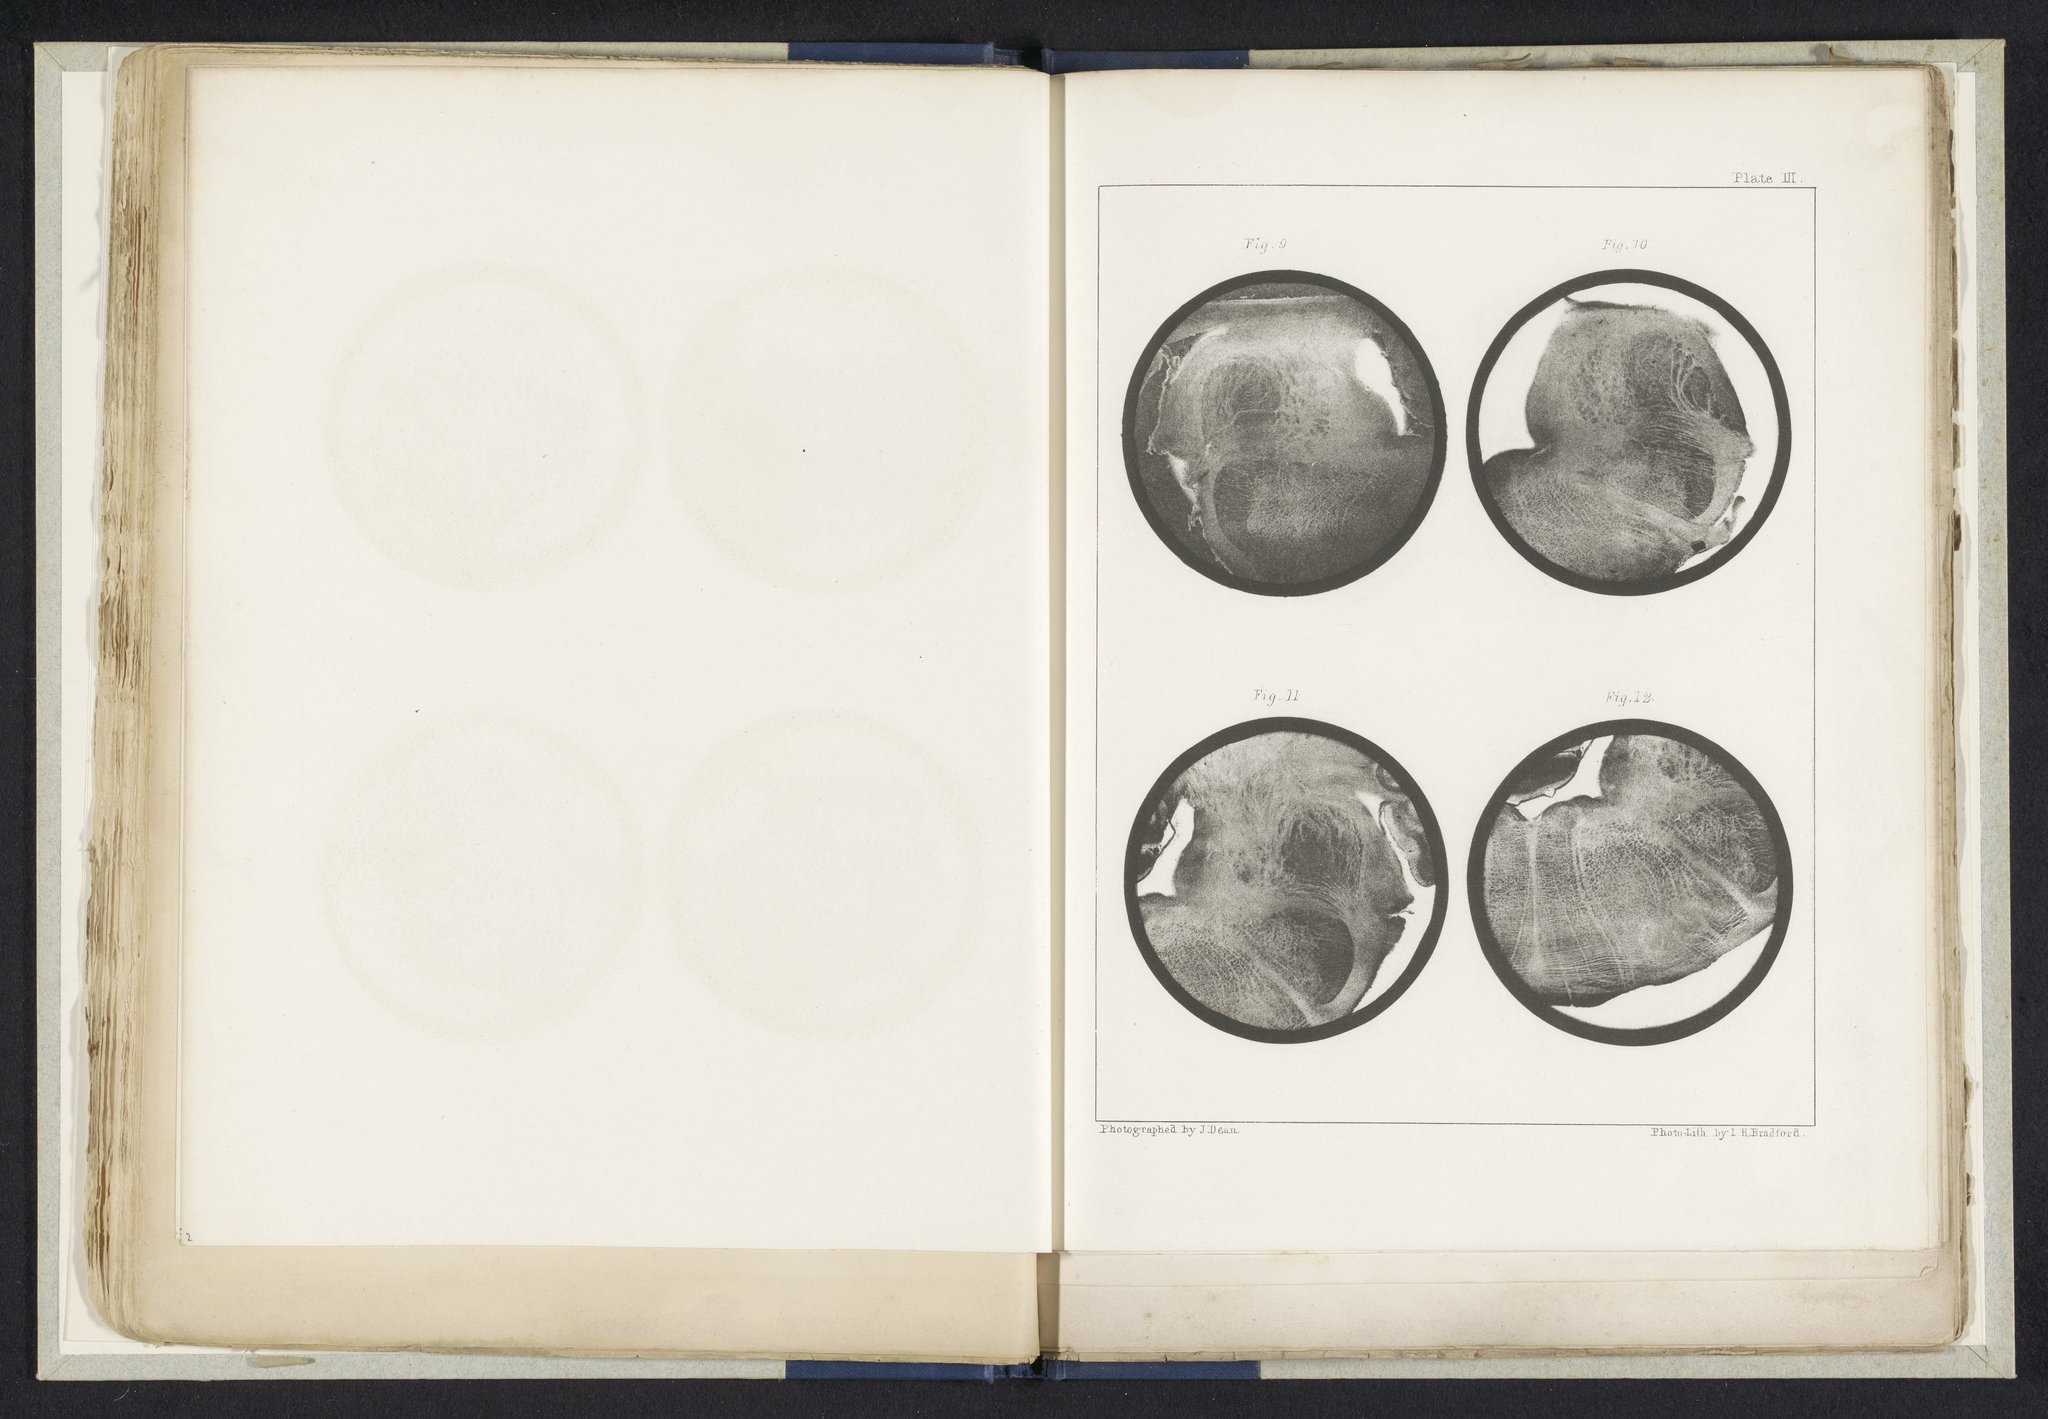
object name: page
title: Vier details van een medulla oblongata van een schaap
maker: john dean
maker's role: fotograaf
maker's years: 1831-1888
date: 1854-1864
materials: paper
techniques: photolithography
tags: brains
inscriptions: number: ‘Plate III. Fig. 9. Fig 10. Fig. 11. Fig. 12.’